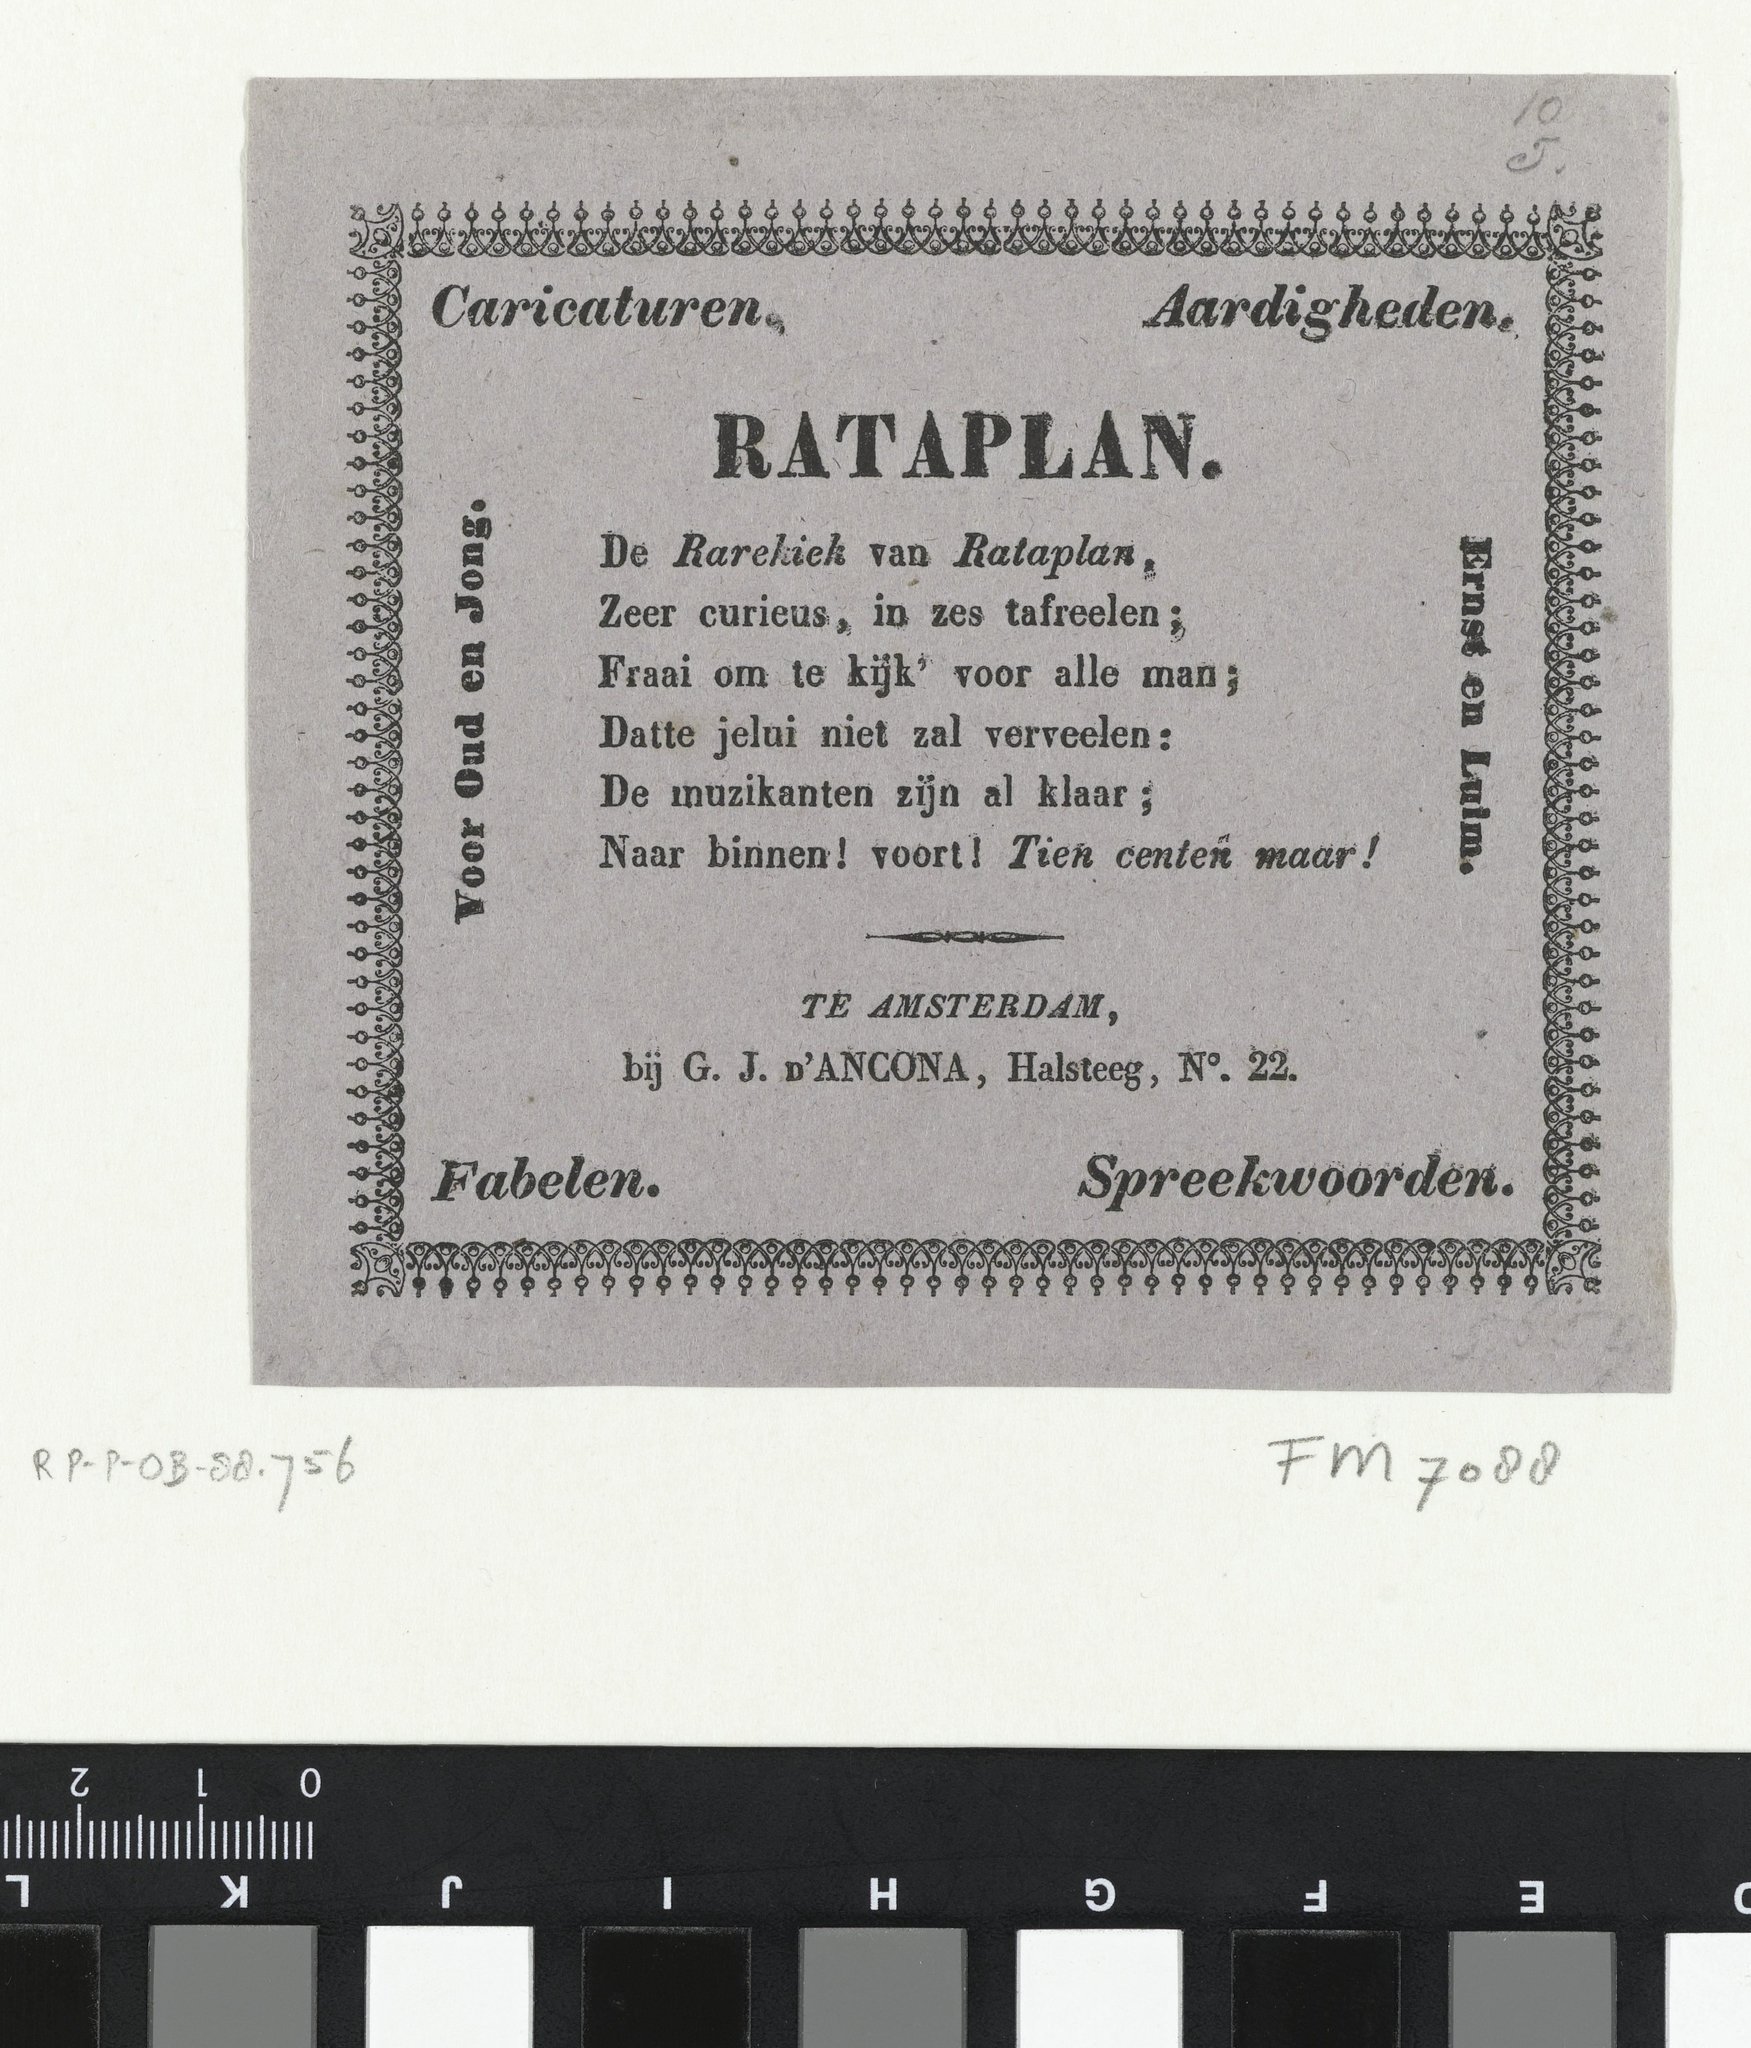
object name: titelblad, titelpagina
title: Titelprent voor een serie van zes humoristische plaatjes, ca. 1845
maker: georgius jacobus d ancona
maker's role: bookseller, publisher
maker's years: 1803-1850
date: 1845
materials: paper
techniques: letterpress printing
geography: amsterdam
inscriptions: collector's mark: Lugt 2228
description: Titelblad met een zesregelig versje. Behorend bij een serie van zes humoristische plaatjes, spotprenten op de Haagse politiek, belastingen en andere maatschappelijke toestanden, ca. 1845.